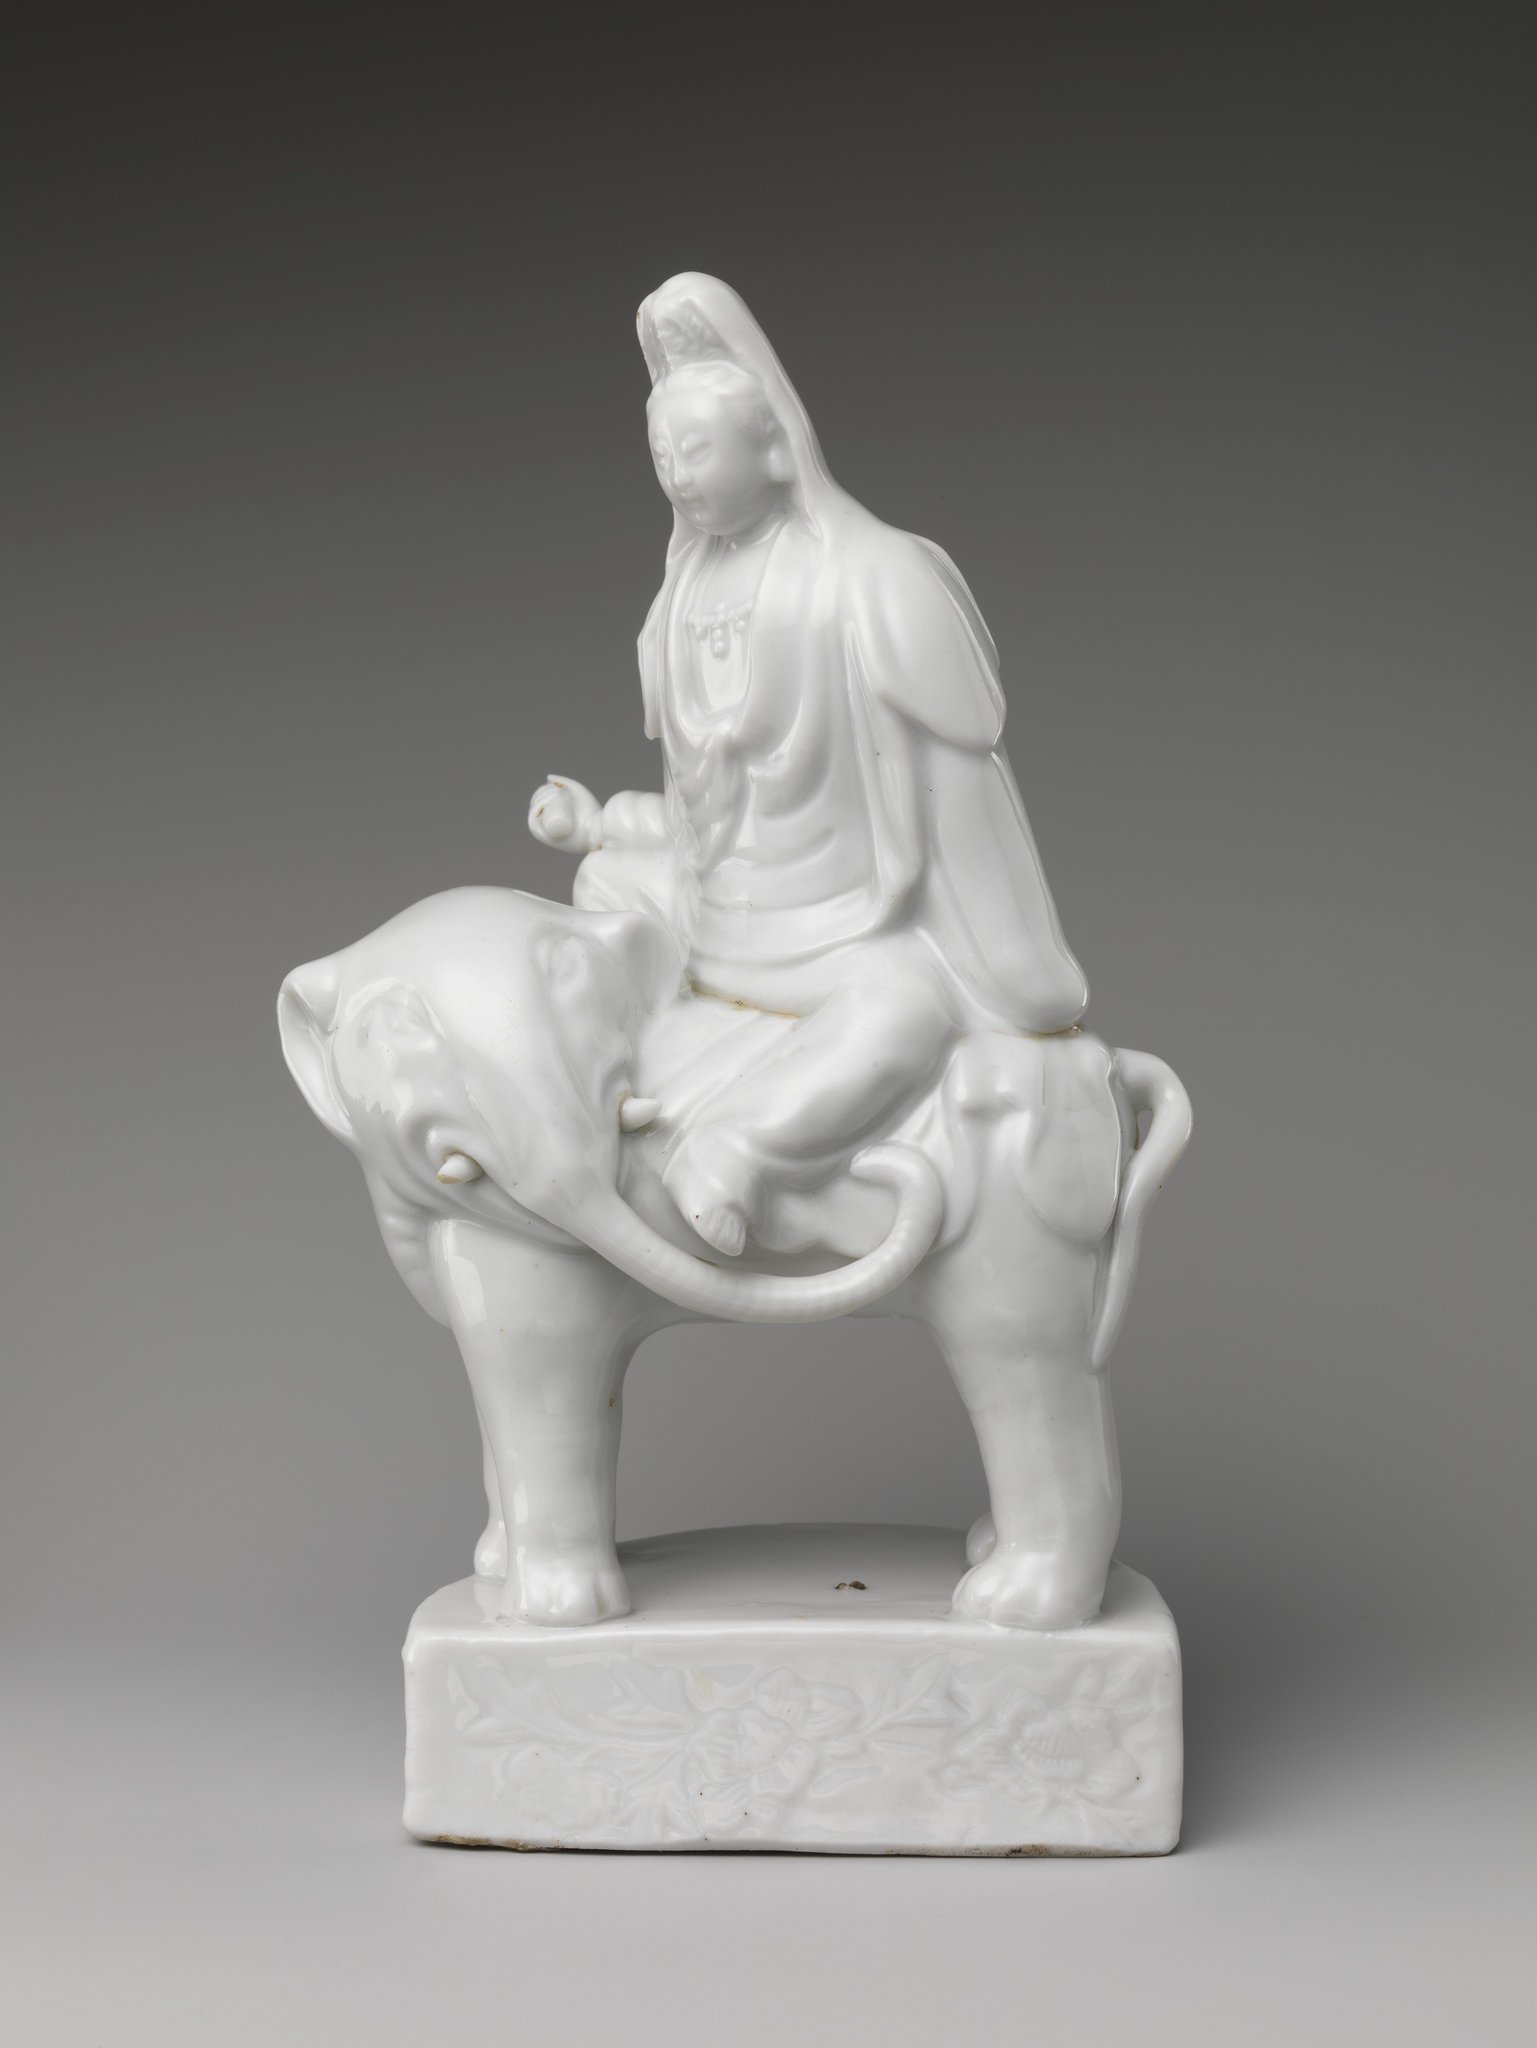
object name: figure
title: Puxian (Samantabhadra, Bodhisattva of Universal Benevolence)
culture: chinese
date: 1667-1700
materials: glaze, porcelain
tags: elephants,buddhism,bodhisattvas